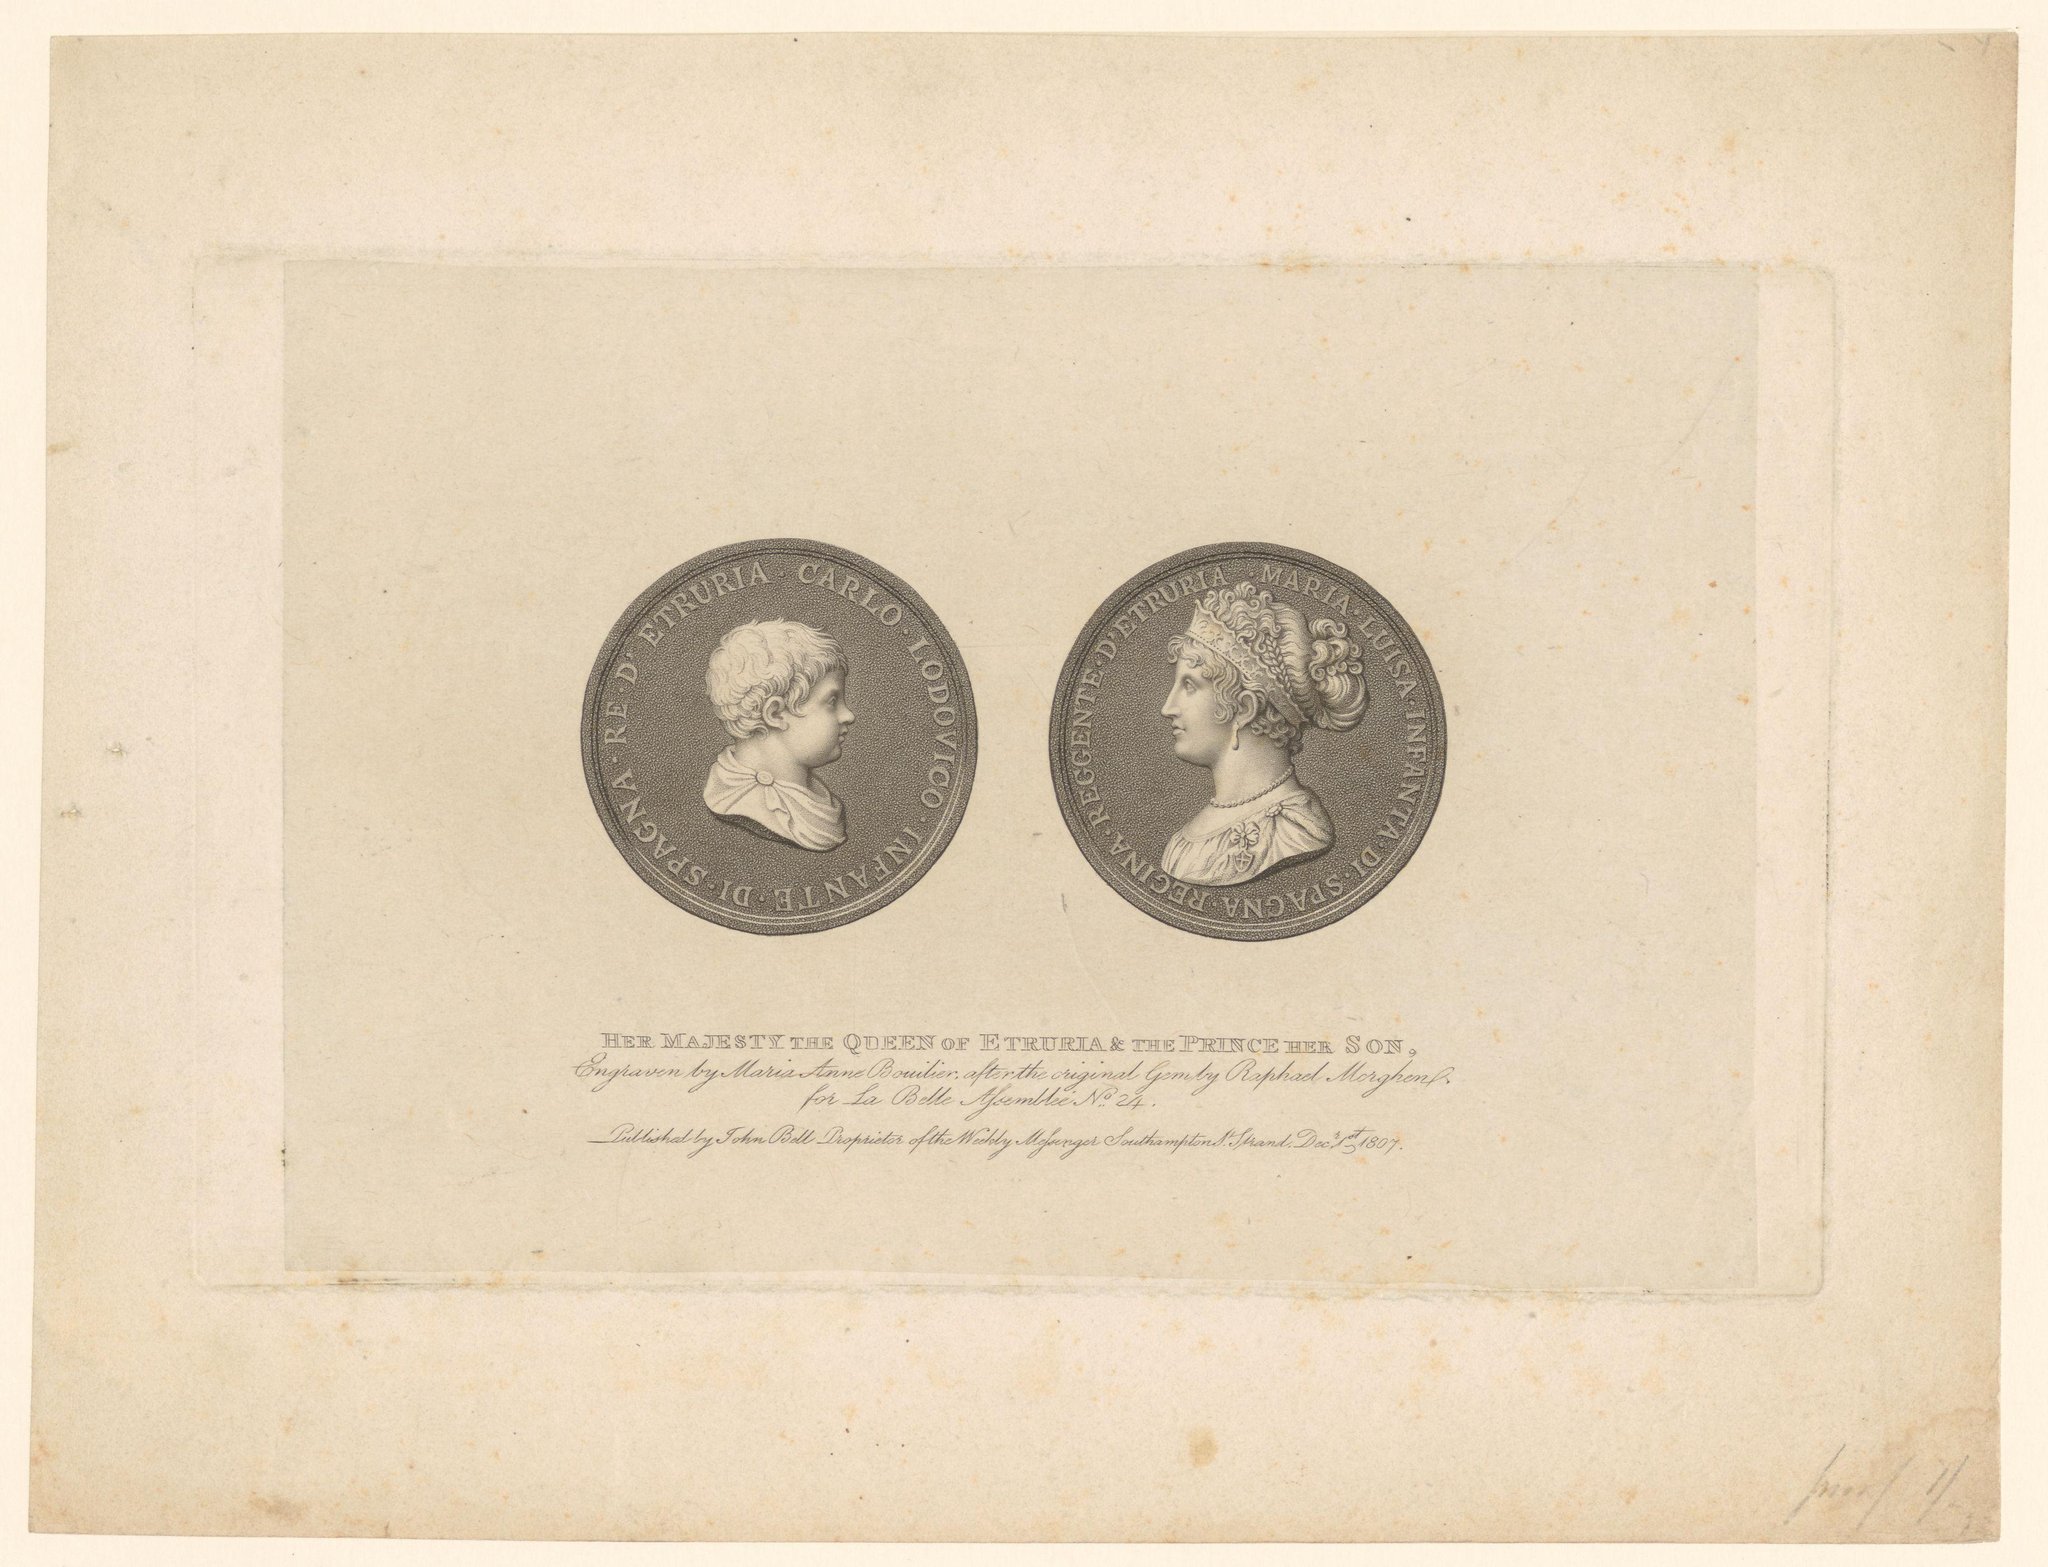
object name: print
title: Twee munten met de portretten van Maria Louisa van Bourbon en haar zoon Karel Lodewijk van Bourbon-Parma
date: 1807-1812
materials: paper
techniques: engraving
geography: london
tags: rome, prince, historical persons, queen, coin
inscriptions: collector's mark: Lugt 2228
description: Prent uit: La Belle Assemblée: or Bell's Court and fashionable Magazine, 1807.